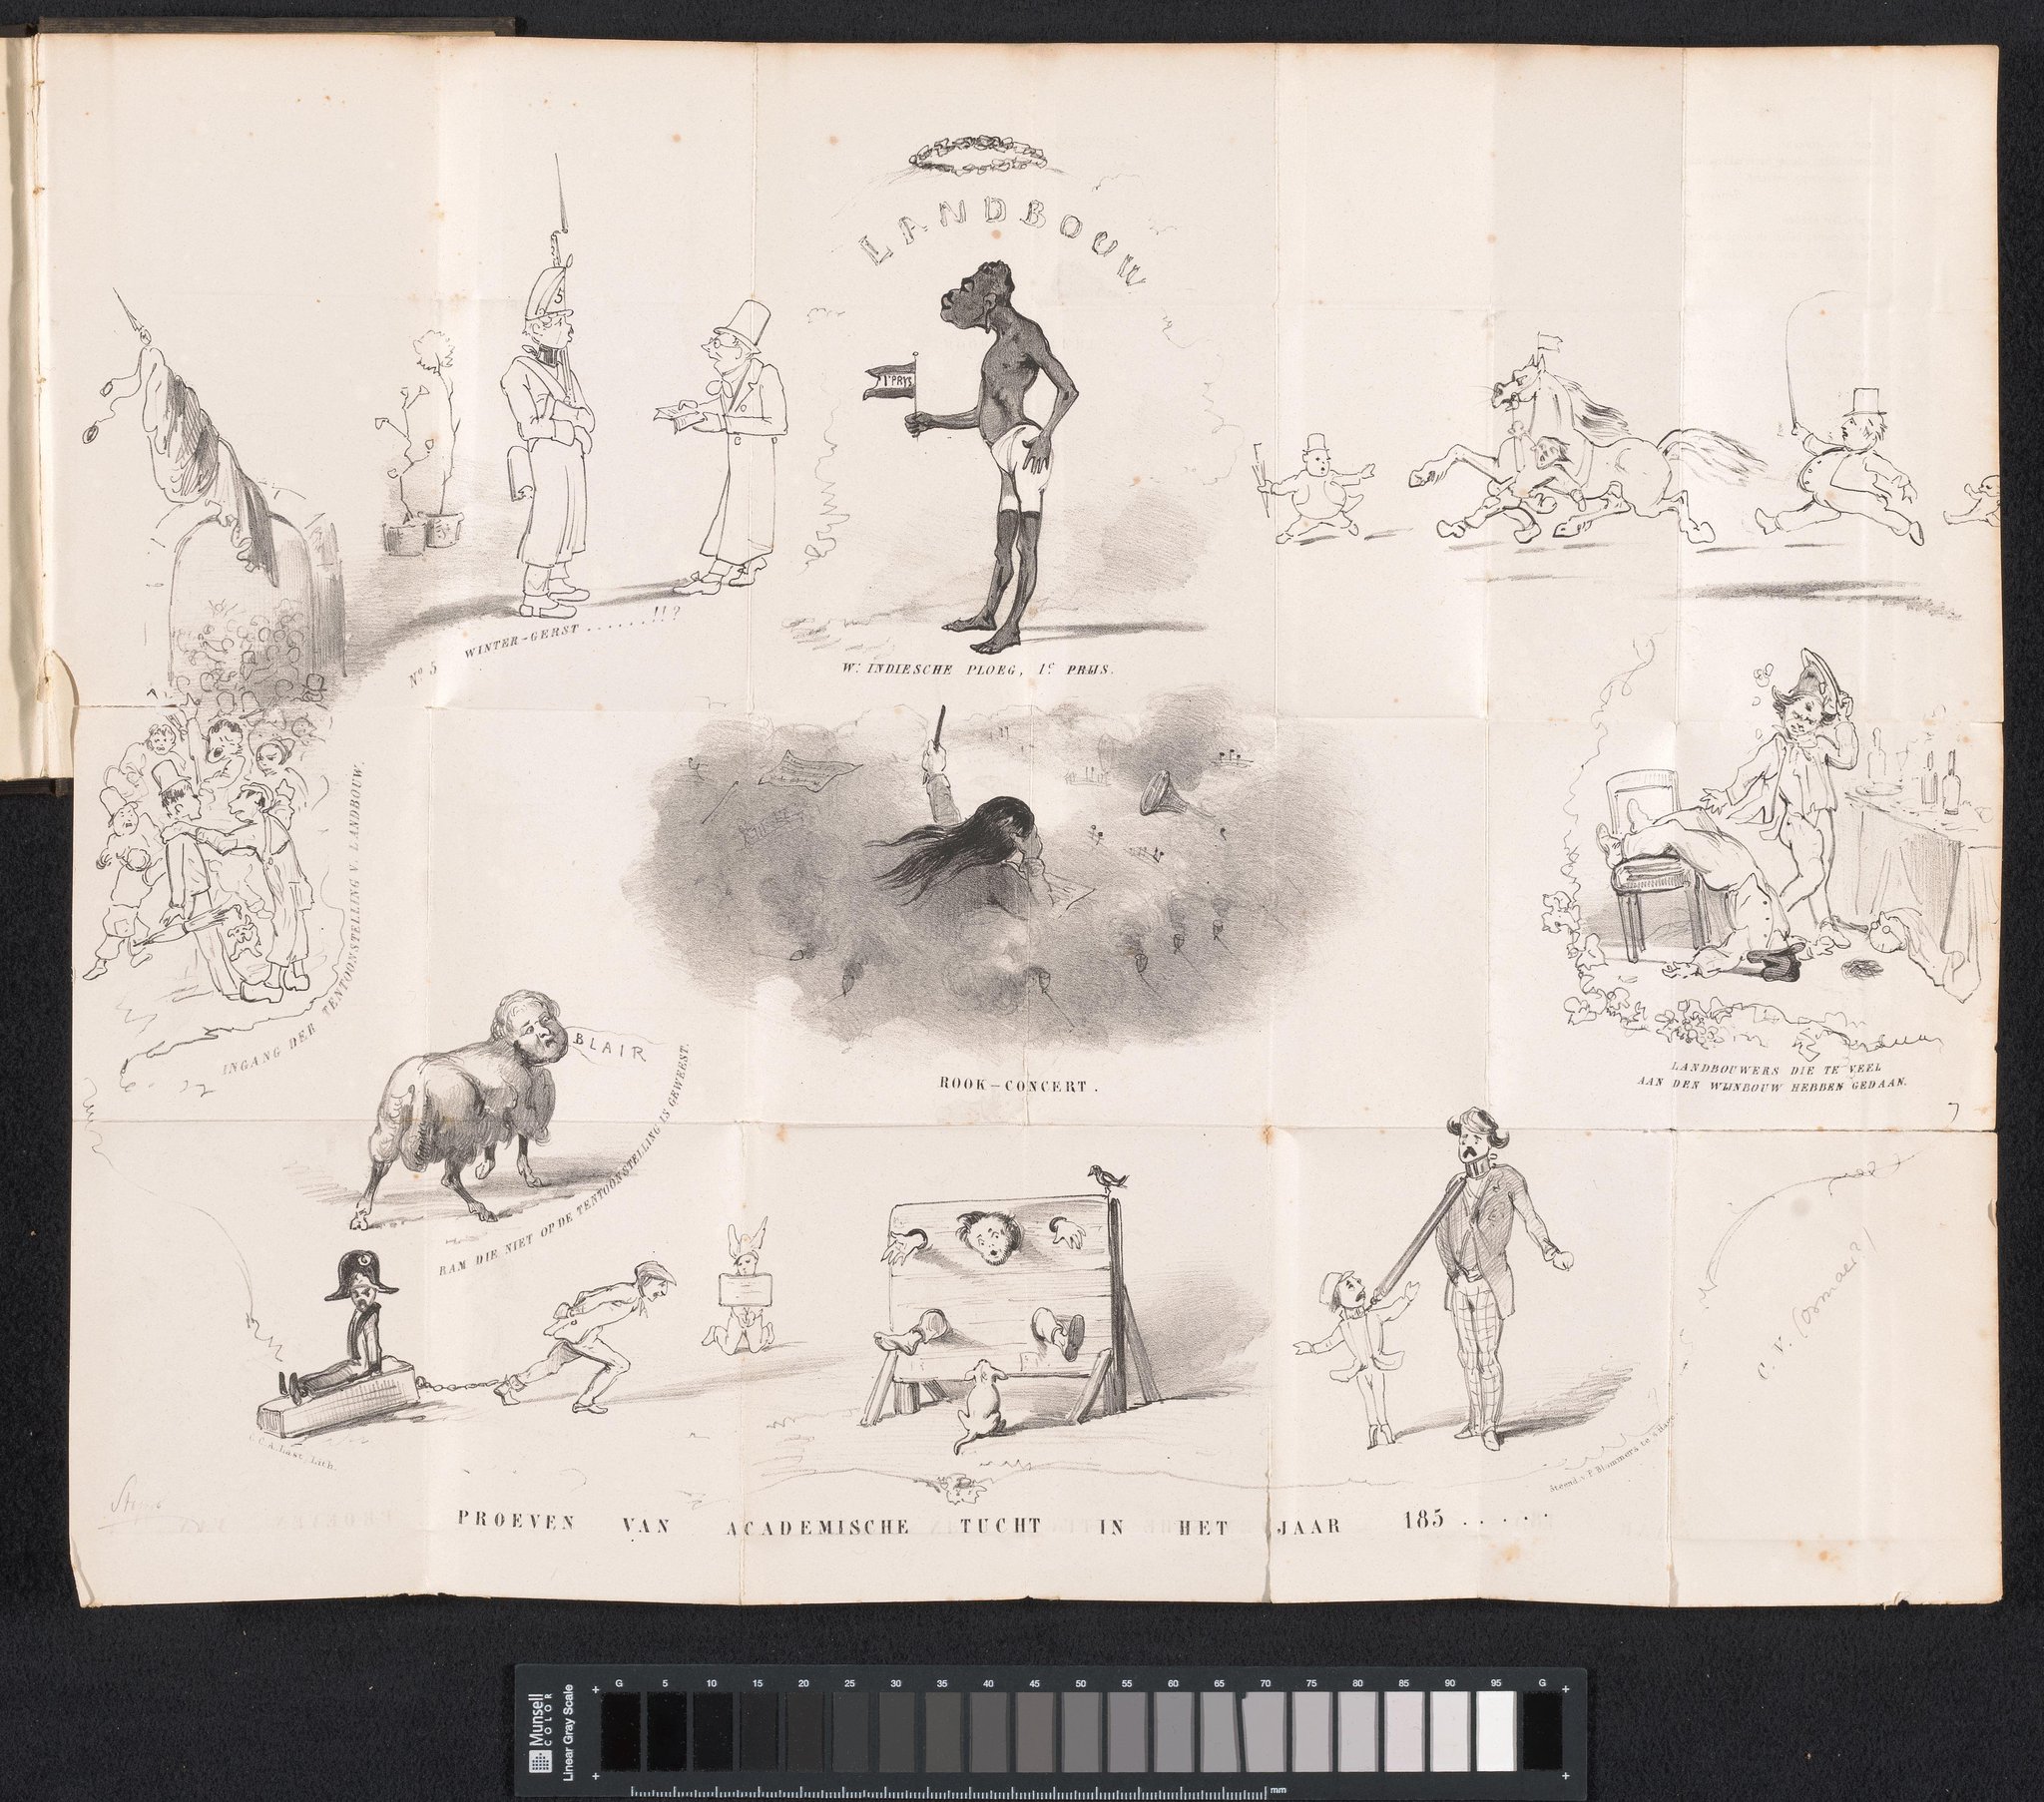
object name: cartoon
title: Proeven van academische tucht in het jaar 185 (...)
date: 1850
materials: paper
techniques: lithograph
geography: leiden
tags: native peoples of the americas, student life, leiden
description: Spotprent in de studentenalmanak van de Universiteit van Leiden van het jaar 1850. Tien voorstellingen over de landbouwtentoonstelling georganiseerd door de Hollandse Maatschappij van Landbouw in 1850 in Leiden. Centraal bovenaan een zwarte West-Indische man met het opschrift 'W: Indiesche Ploeg, 1e prijs'.